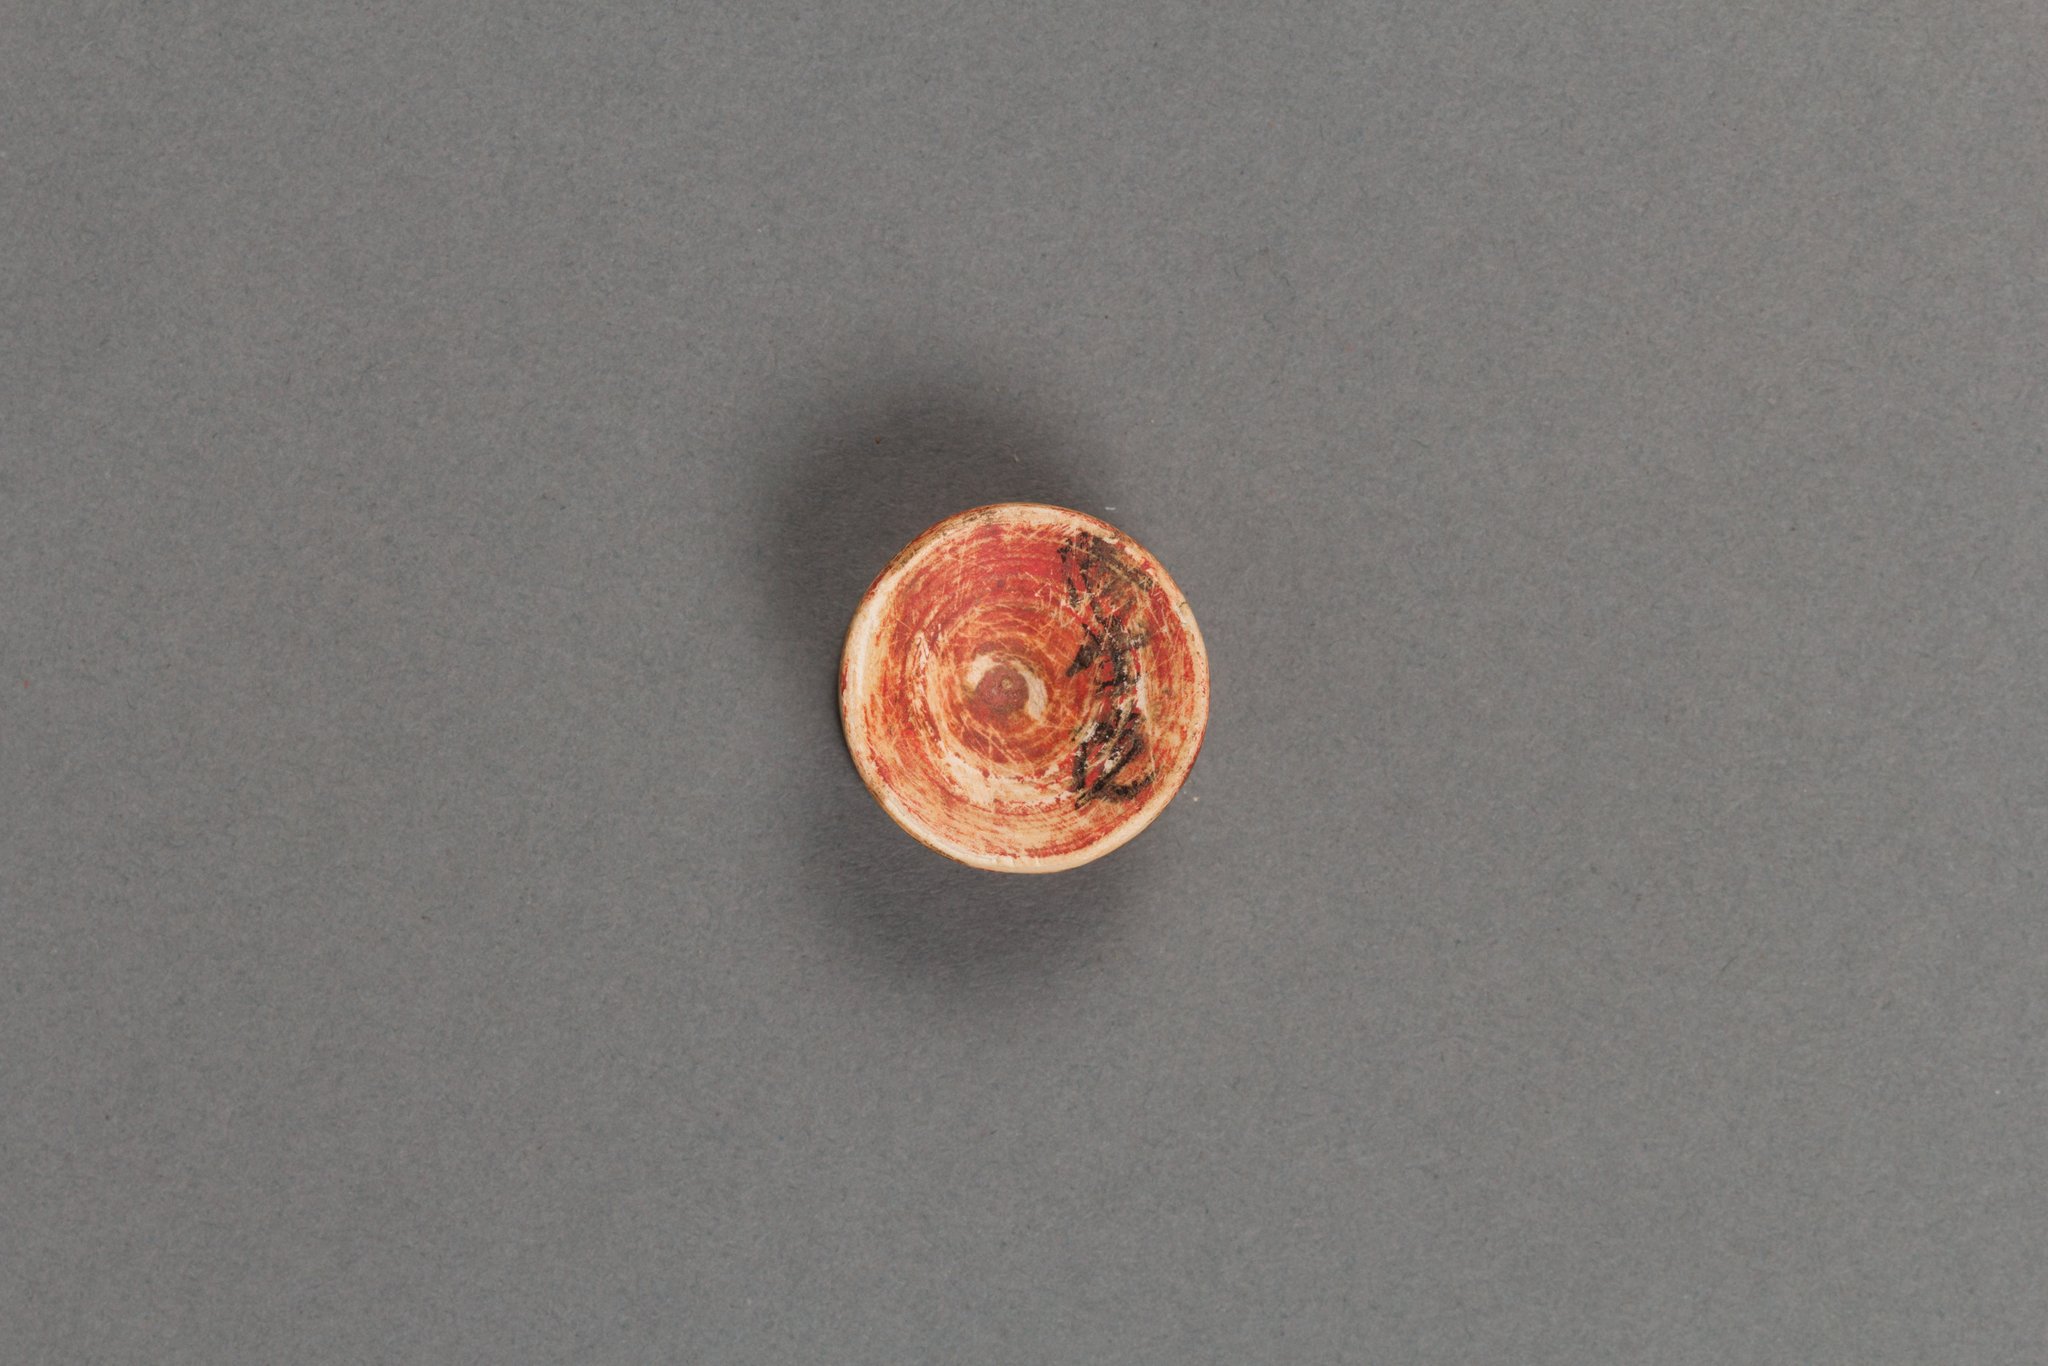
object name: ornament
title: One of a Group of Bone Ornaments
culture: japanese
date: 1000-300 BCE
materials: bone